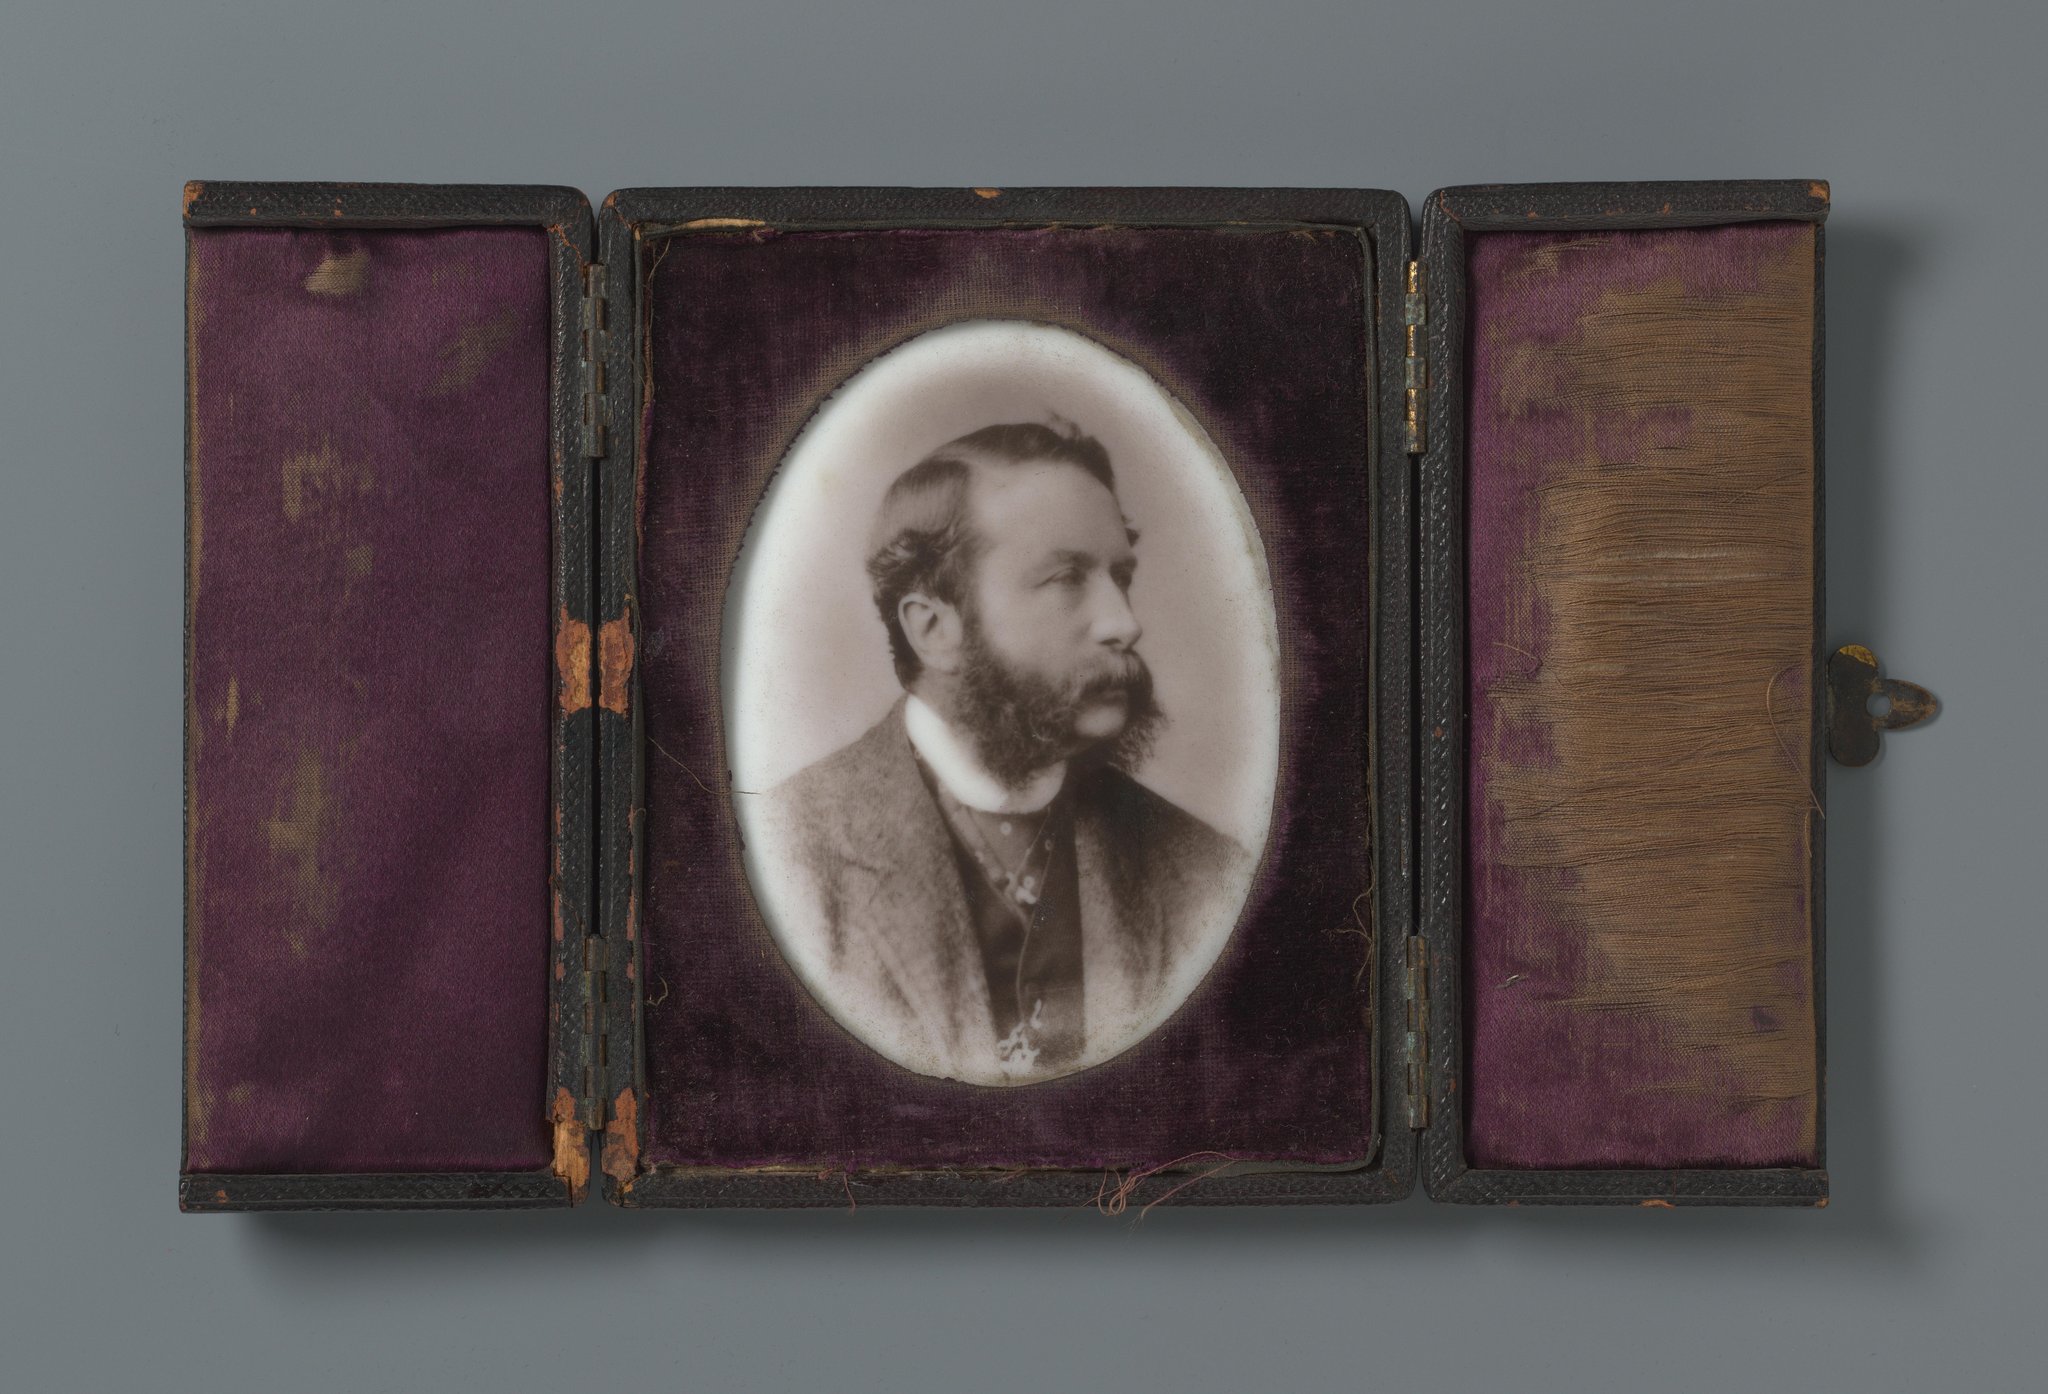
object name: photograph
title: Portret van een onbekende man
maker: Anonymous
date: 1890-1920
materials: cardboard, ceramic, metal, velvet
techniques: photoceramics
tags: adult man, anonymous historical person portrayed